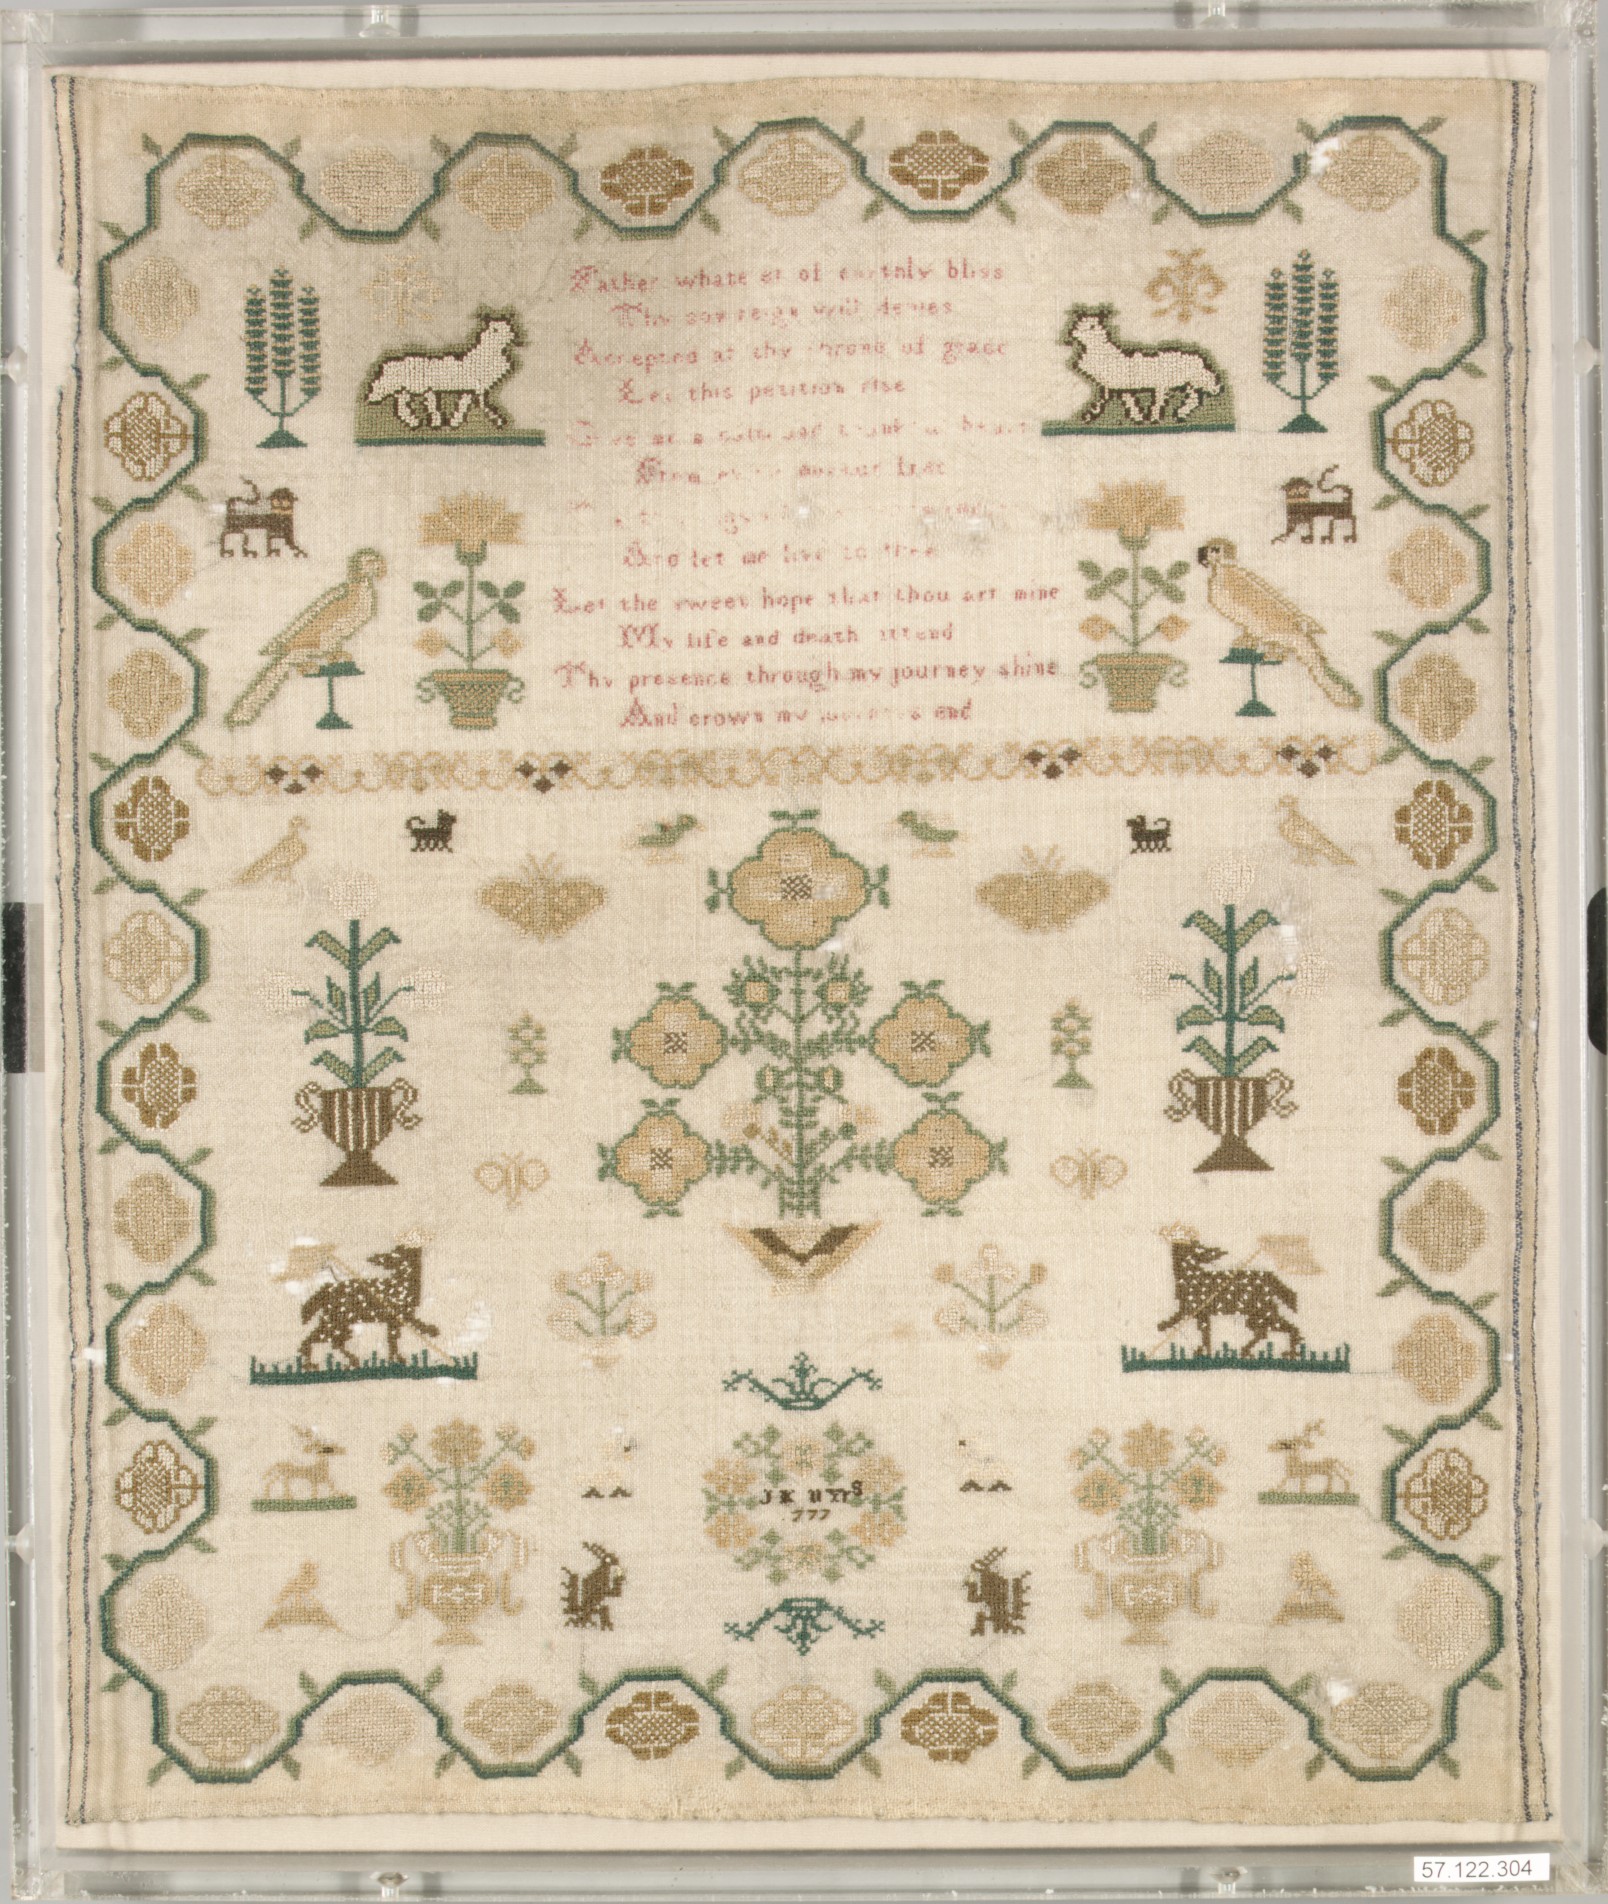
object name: sampler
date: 1777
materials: silk, wool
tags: animals,birds